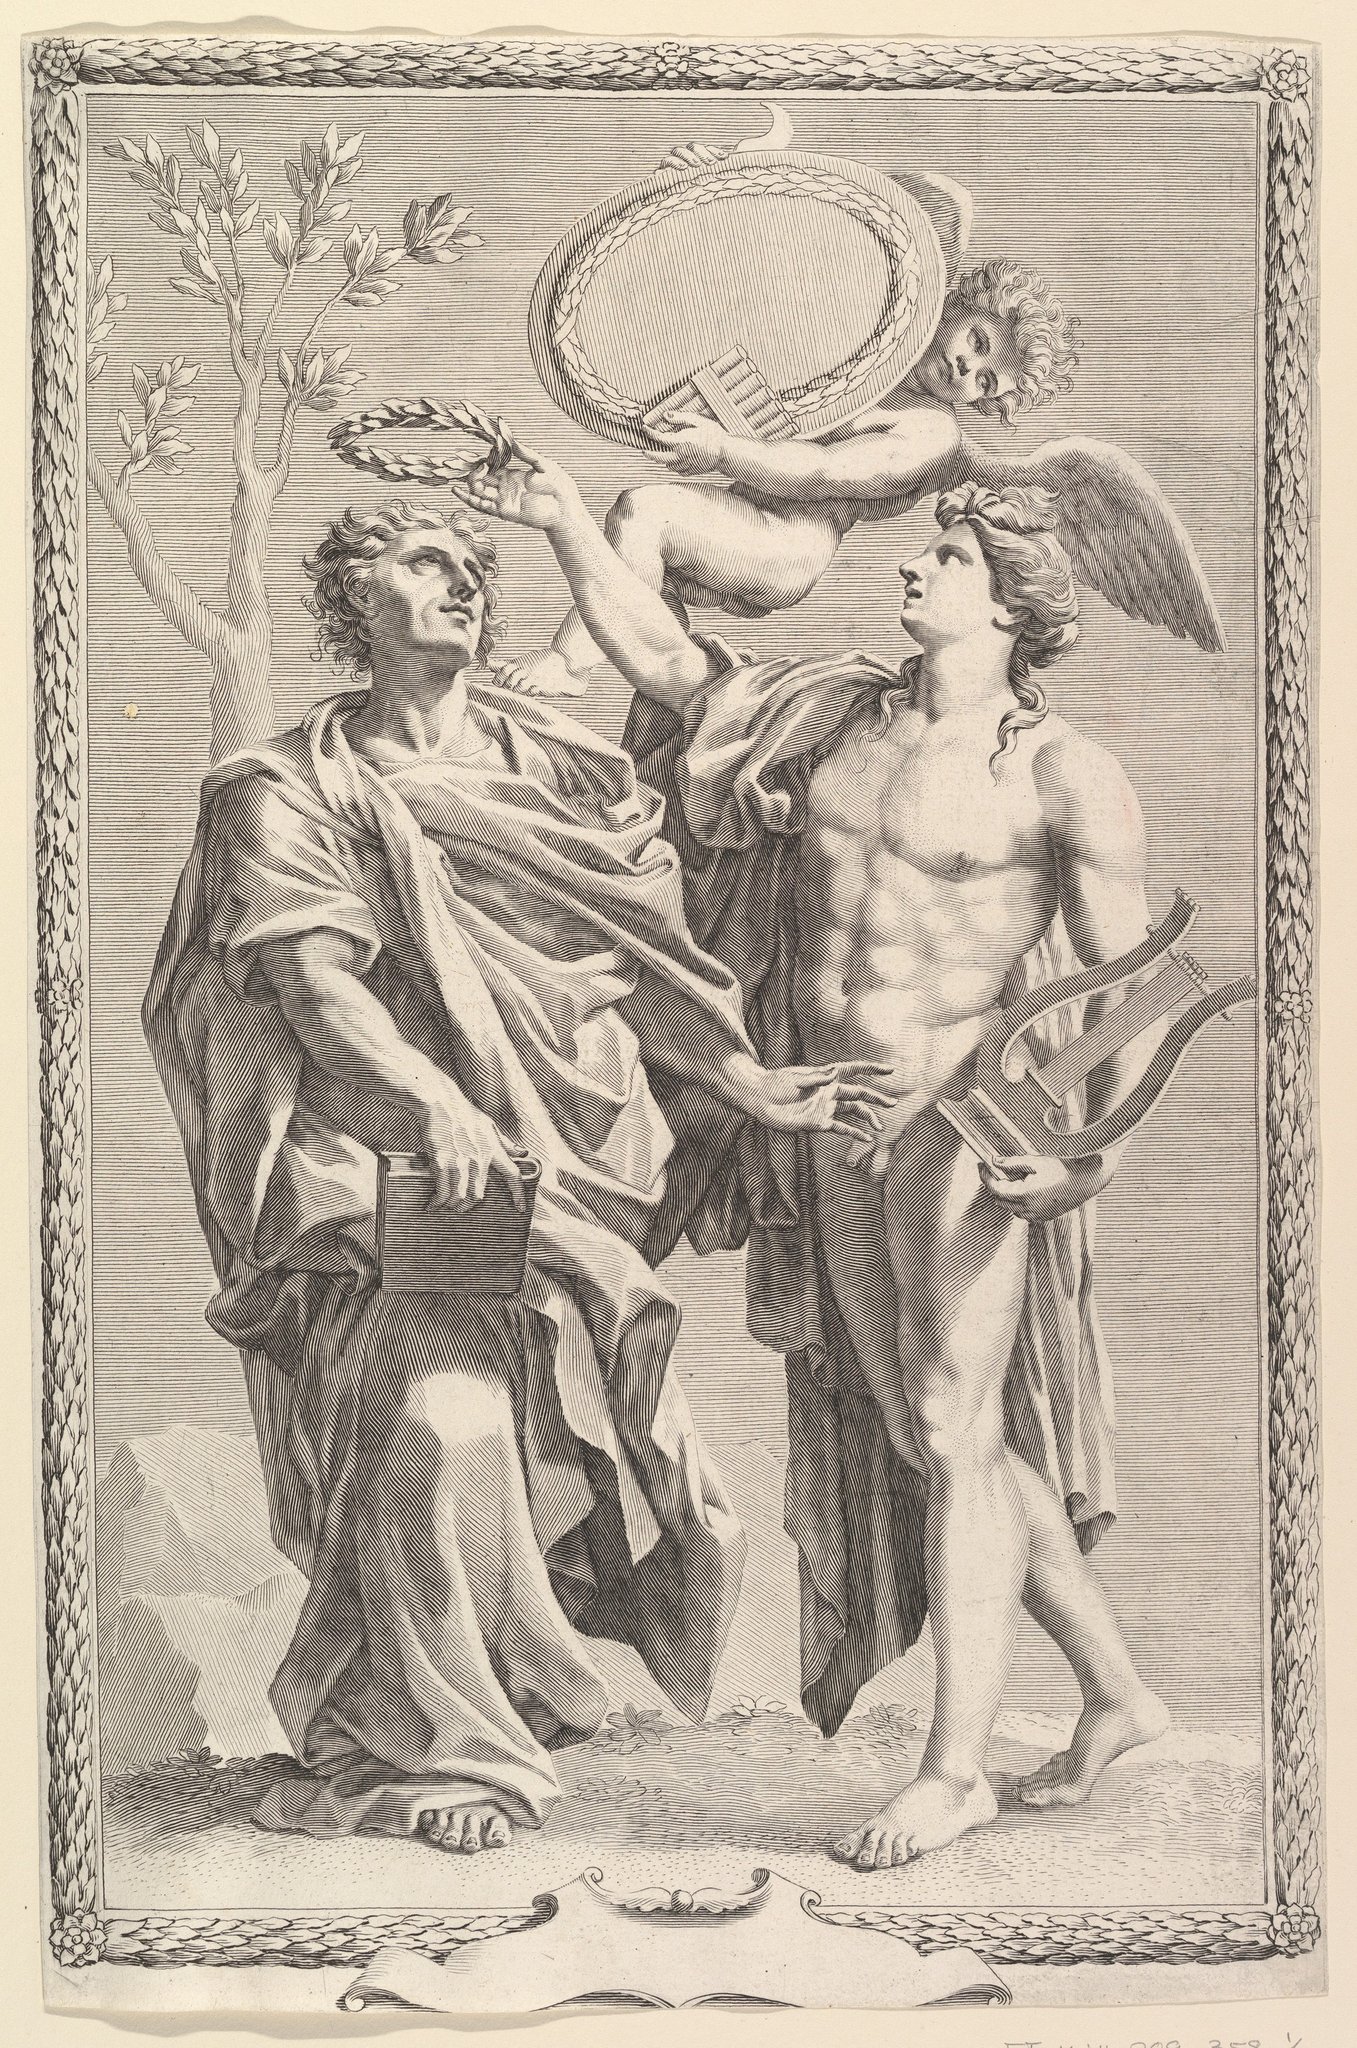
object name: print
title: Frontispiece: Virgil, Publii Virgilii Maronis Opera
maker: claude mellan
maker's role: artist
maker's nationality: french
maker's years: 1598-1688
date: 1641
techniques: engraving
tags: musical instruments,men,male nudes